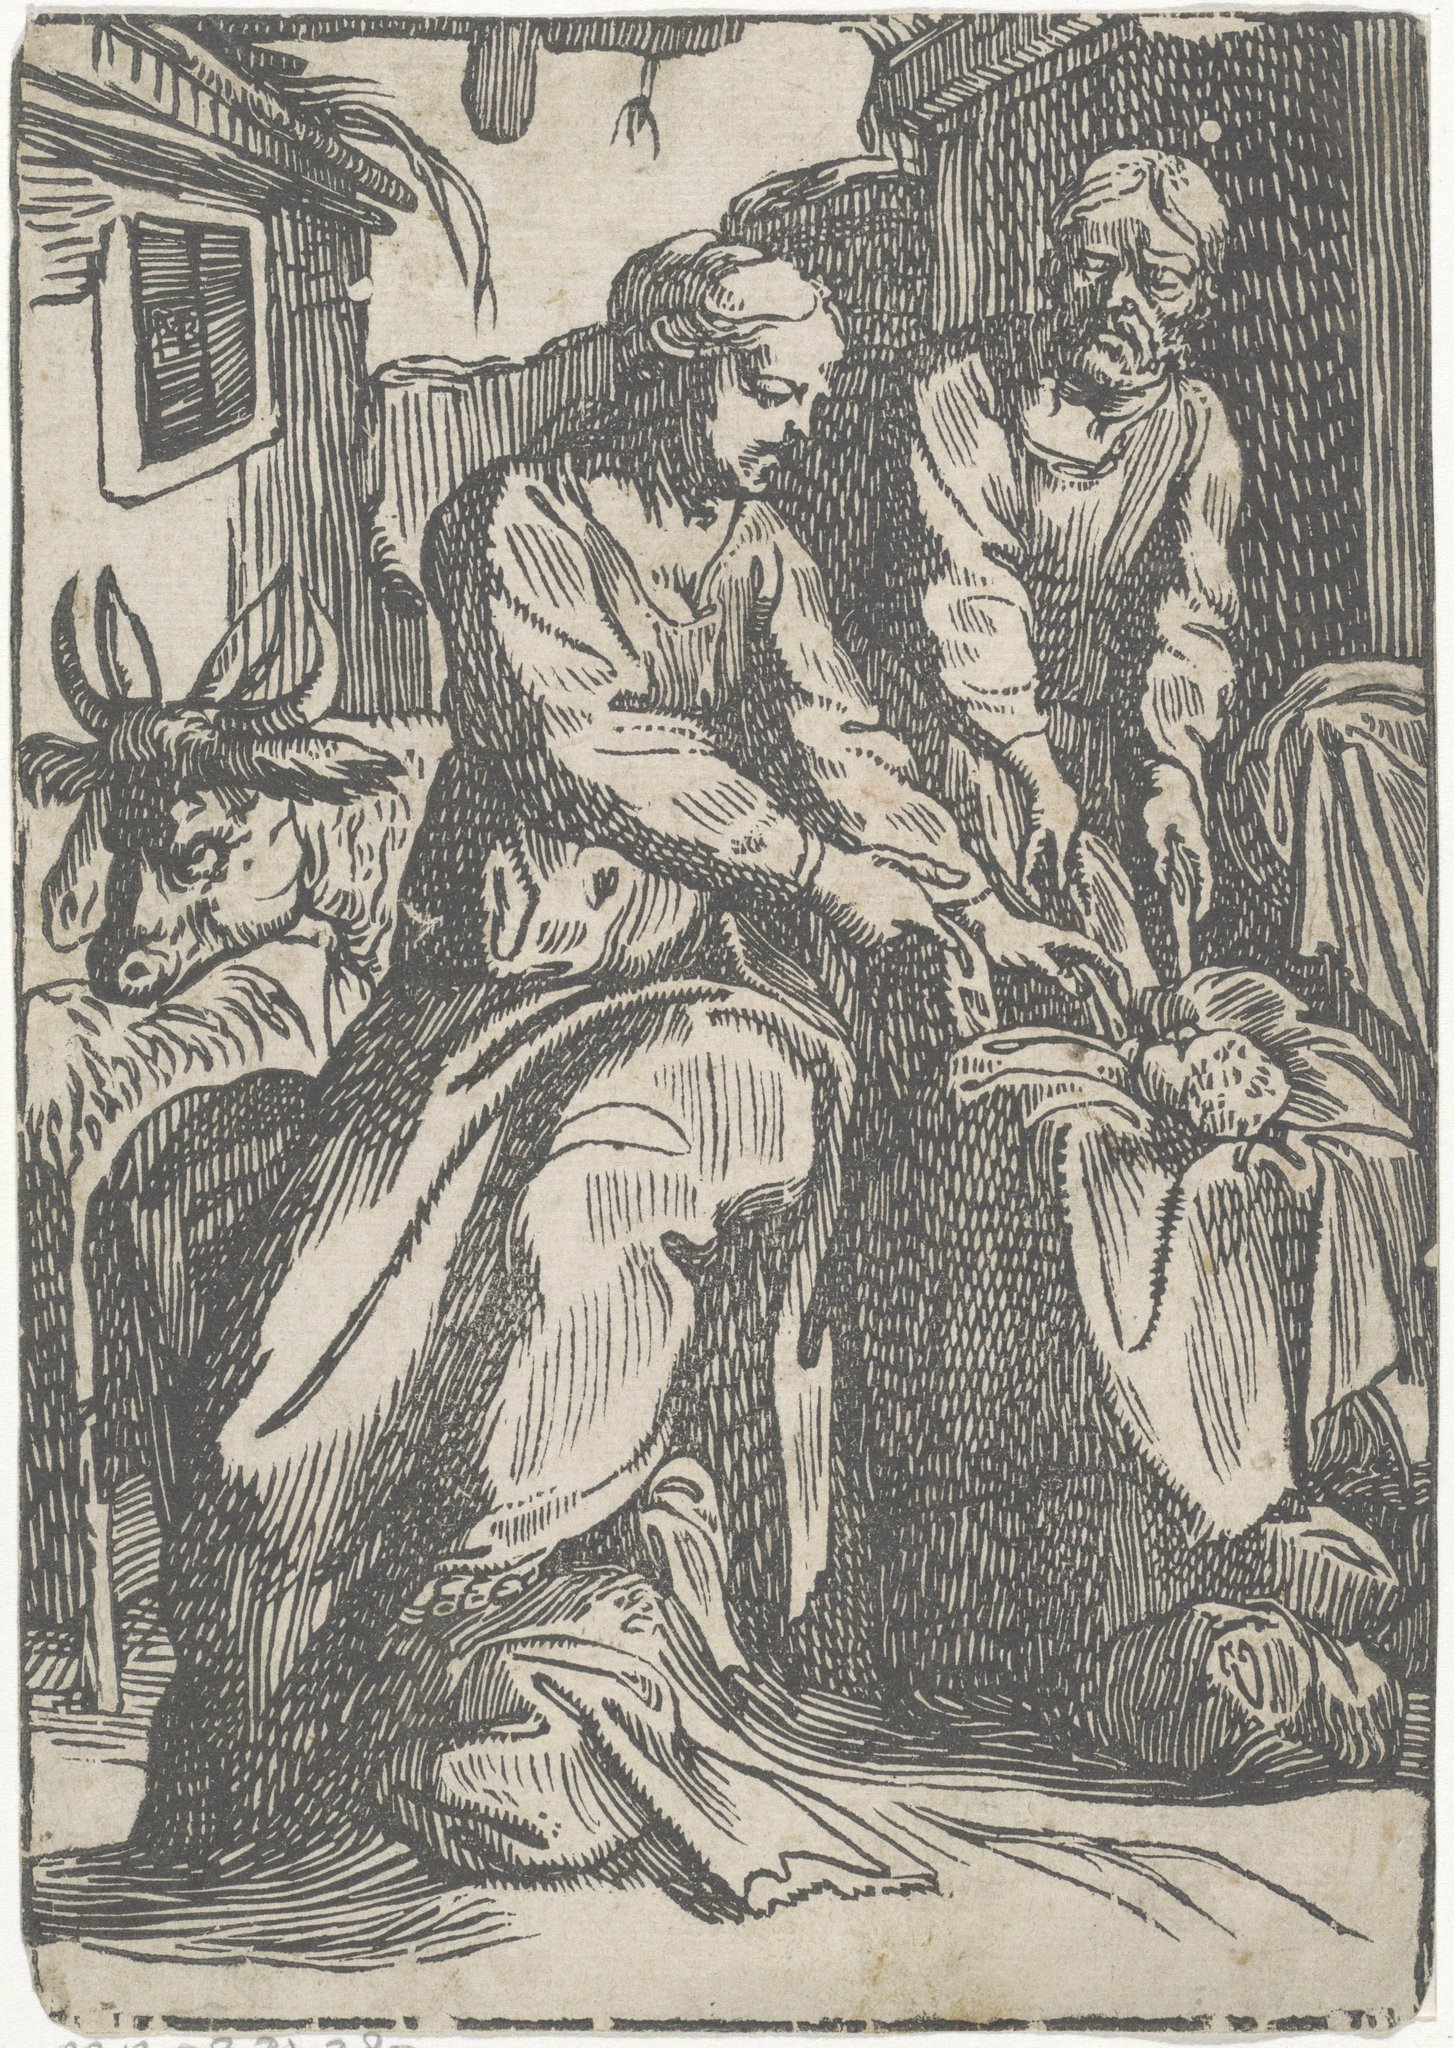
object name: print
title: Geboorte van Christus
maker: moyses van wtenbrouck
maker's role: painter, print maker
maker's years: 1590-1647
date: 1615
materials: paper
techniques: woodcut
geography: the hague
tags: mary, joseph and the new-born christ (nativity)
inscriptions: collector's mark: Lugt 240, collector's mark: Lugt 2228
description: Maria en Jozef in de stal met de os en de ezel naast de kribbe met het Christuskind.